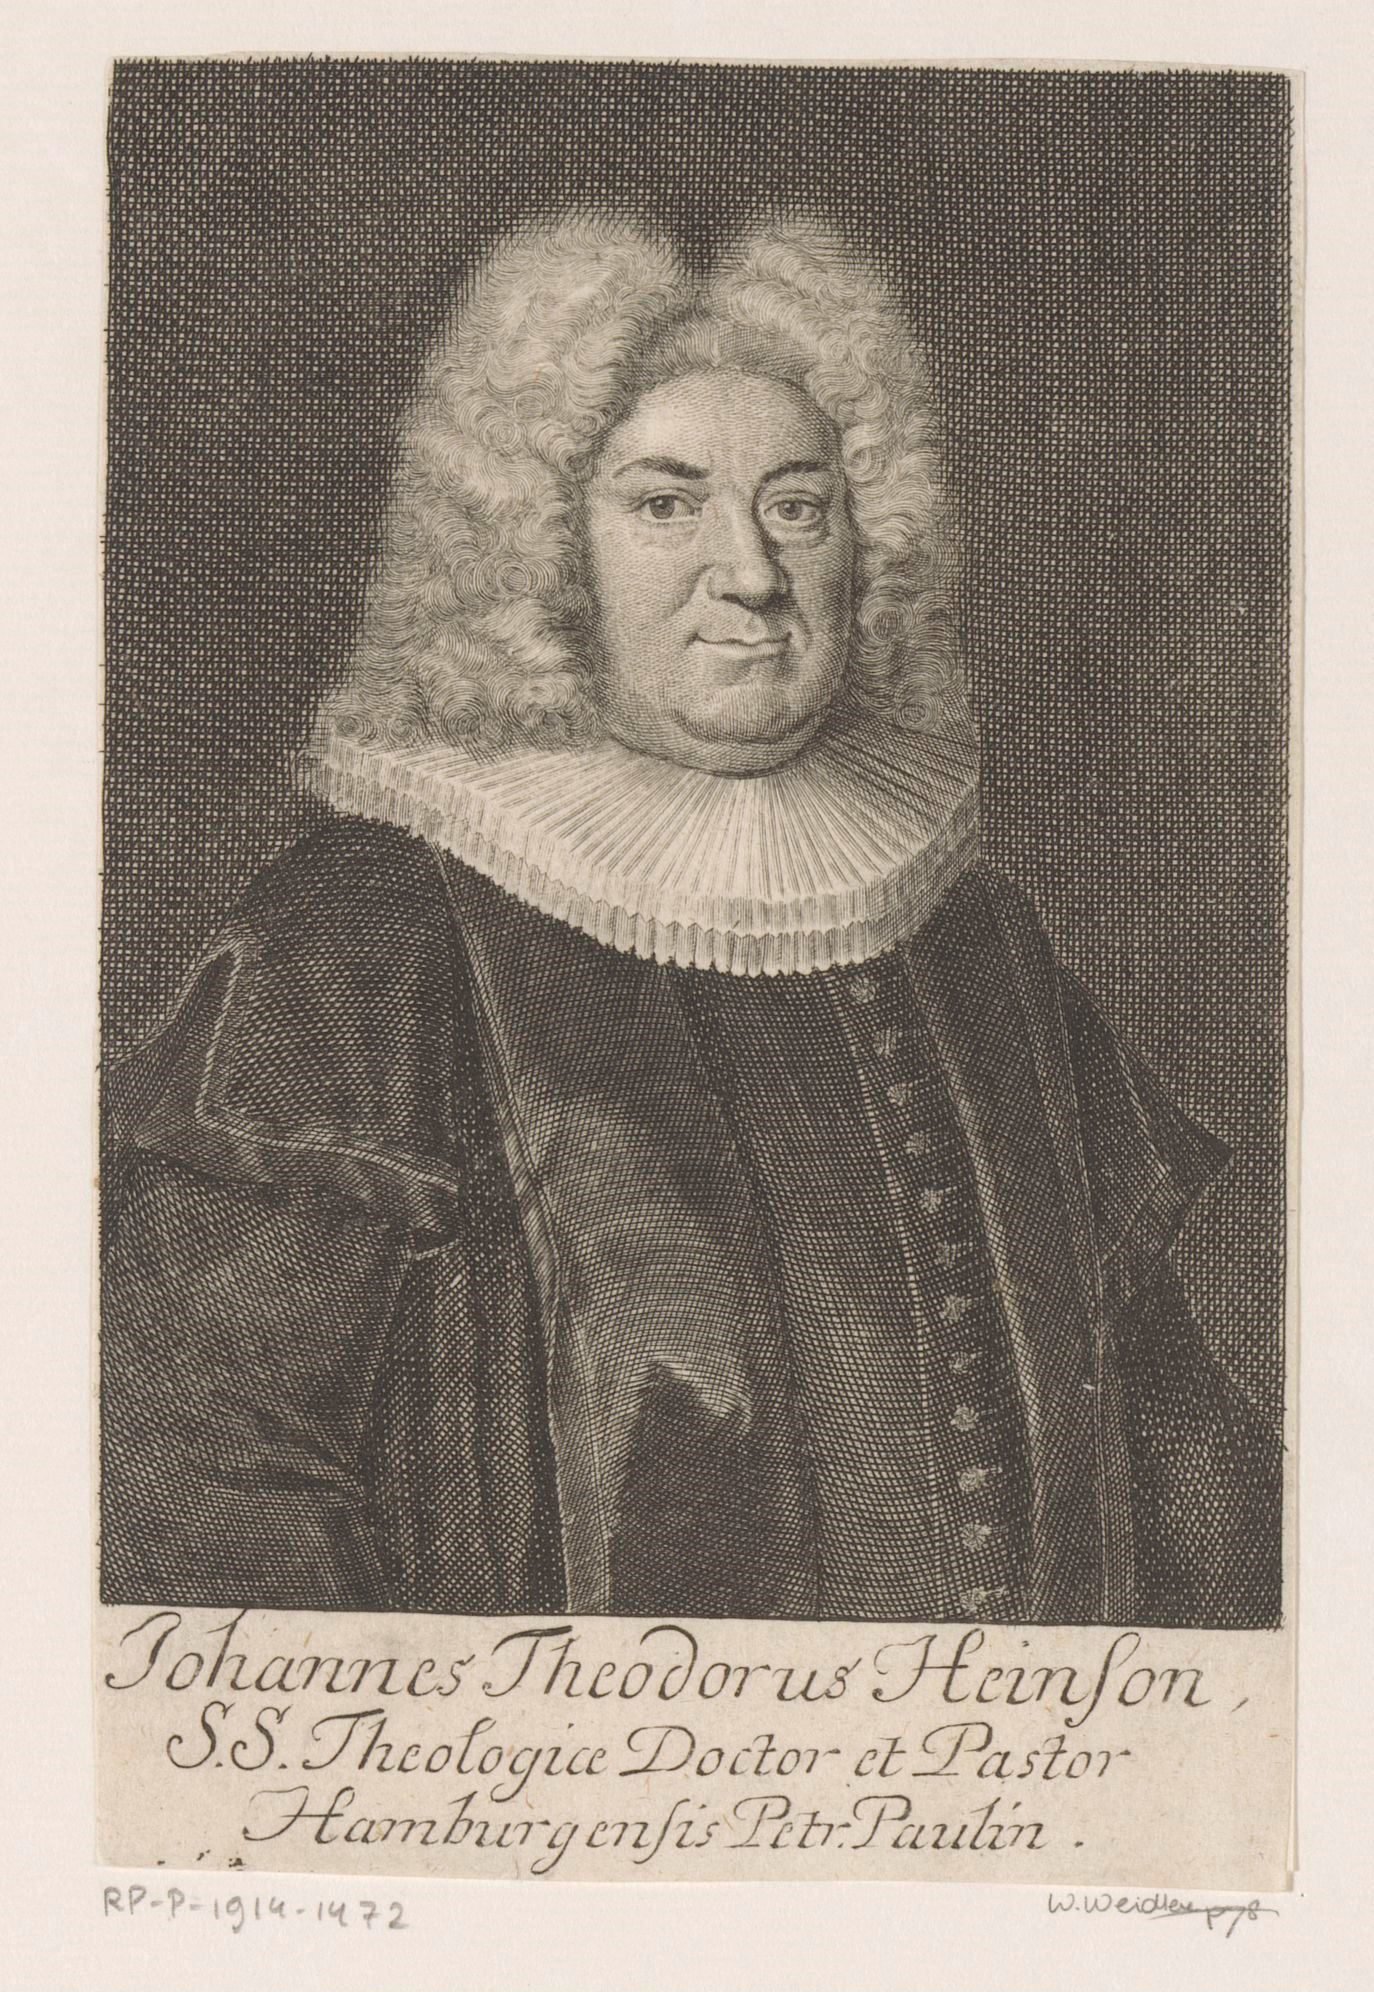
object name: print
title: Portret van Johann Theodor Heinson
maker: martin bernigeroth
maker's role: print maker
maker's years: 1670-1733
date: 1727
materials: paper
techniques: engraving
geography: leipzig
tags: historical persons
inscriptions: collector's mark: Lugt 2228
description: Prent ook gebruikt in: Deutsche Acta Eruditorum (...). dl. 122. Leipzig: Johann Gottlieb Gleditsch, 1727.